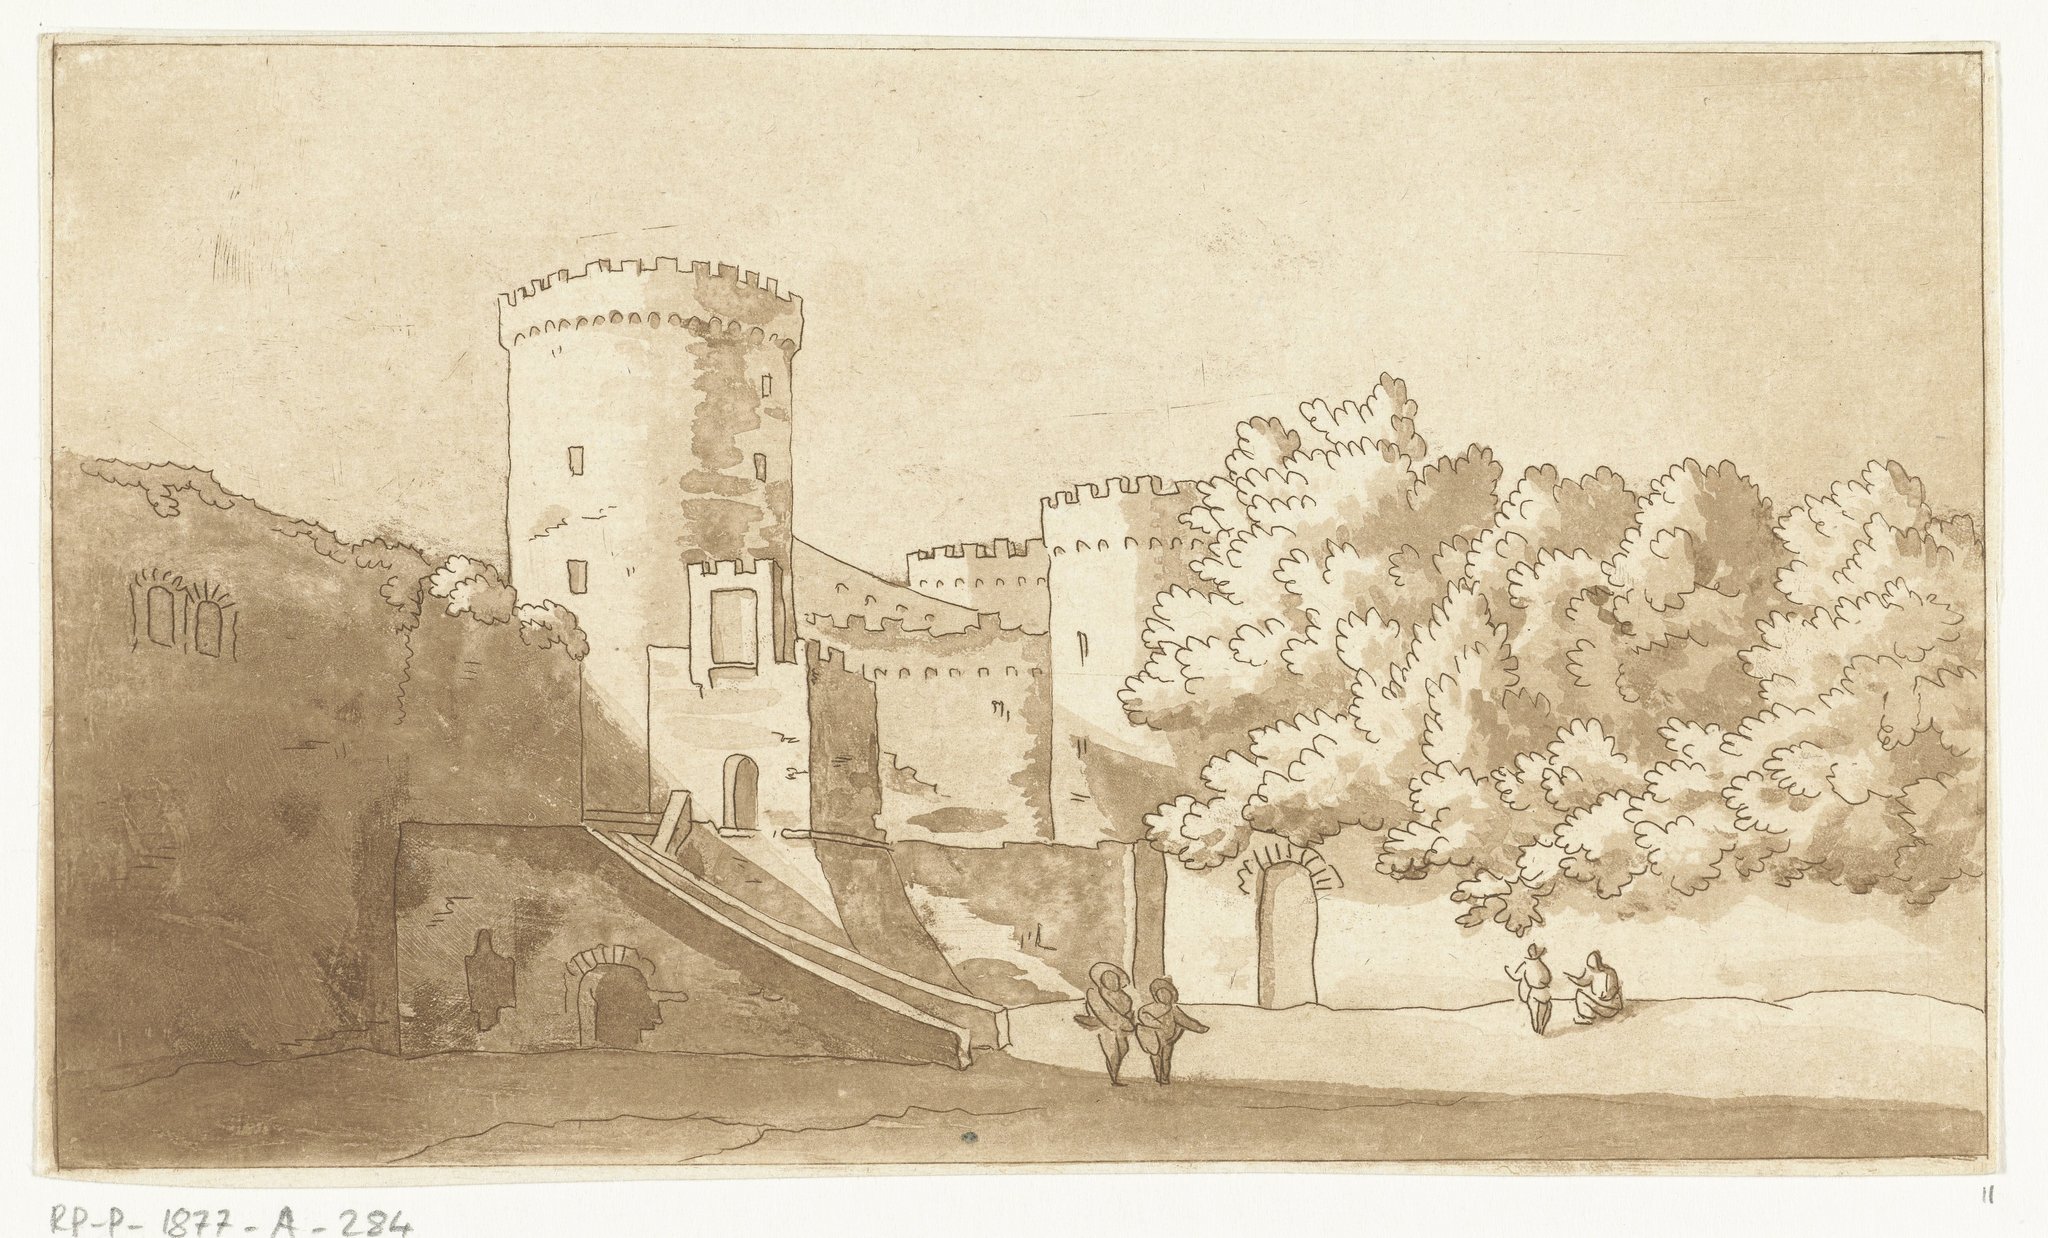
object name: print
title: Muur van een burcht met torens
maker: anthonie van den bos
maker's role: draughtsman, print maker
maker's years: 1763-1838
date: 1778-1838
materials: paper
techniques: aquatint, etching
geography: netherlands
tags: castle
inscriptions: collector's mark: Lugt 2228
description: Naar een tekening in Parijs, Fondation Custodia (coll. F. Lugt), Parijs, inv.nr. 6481, fol. 11, met het opschrift 'Castel Gandolfo'.